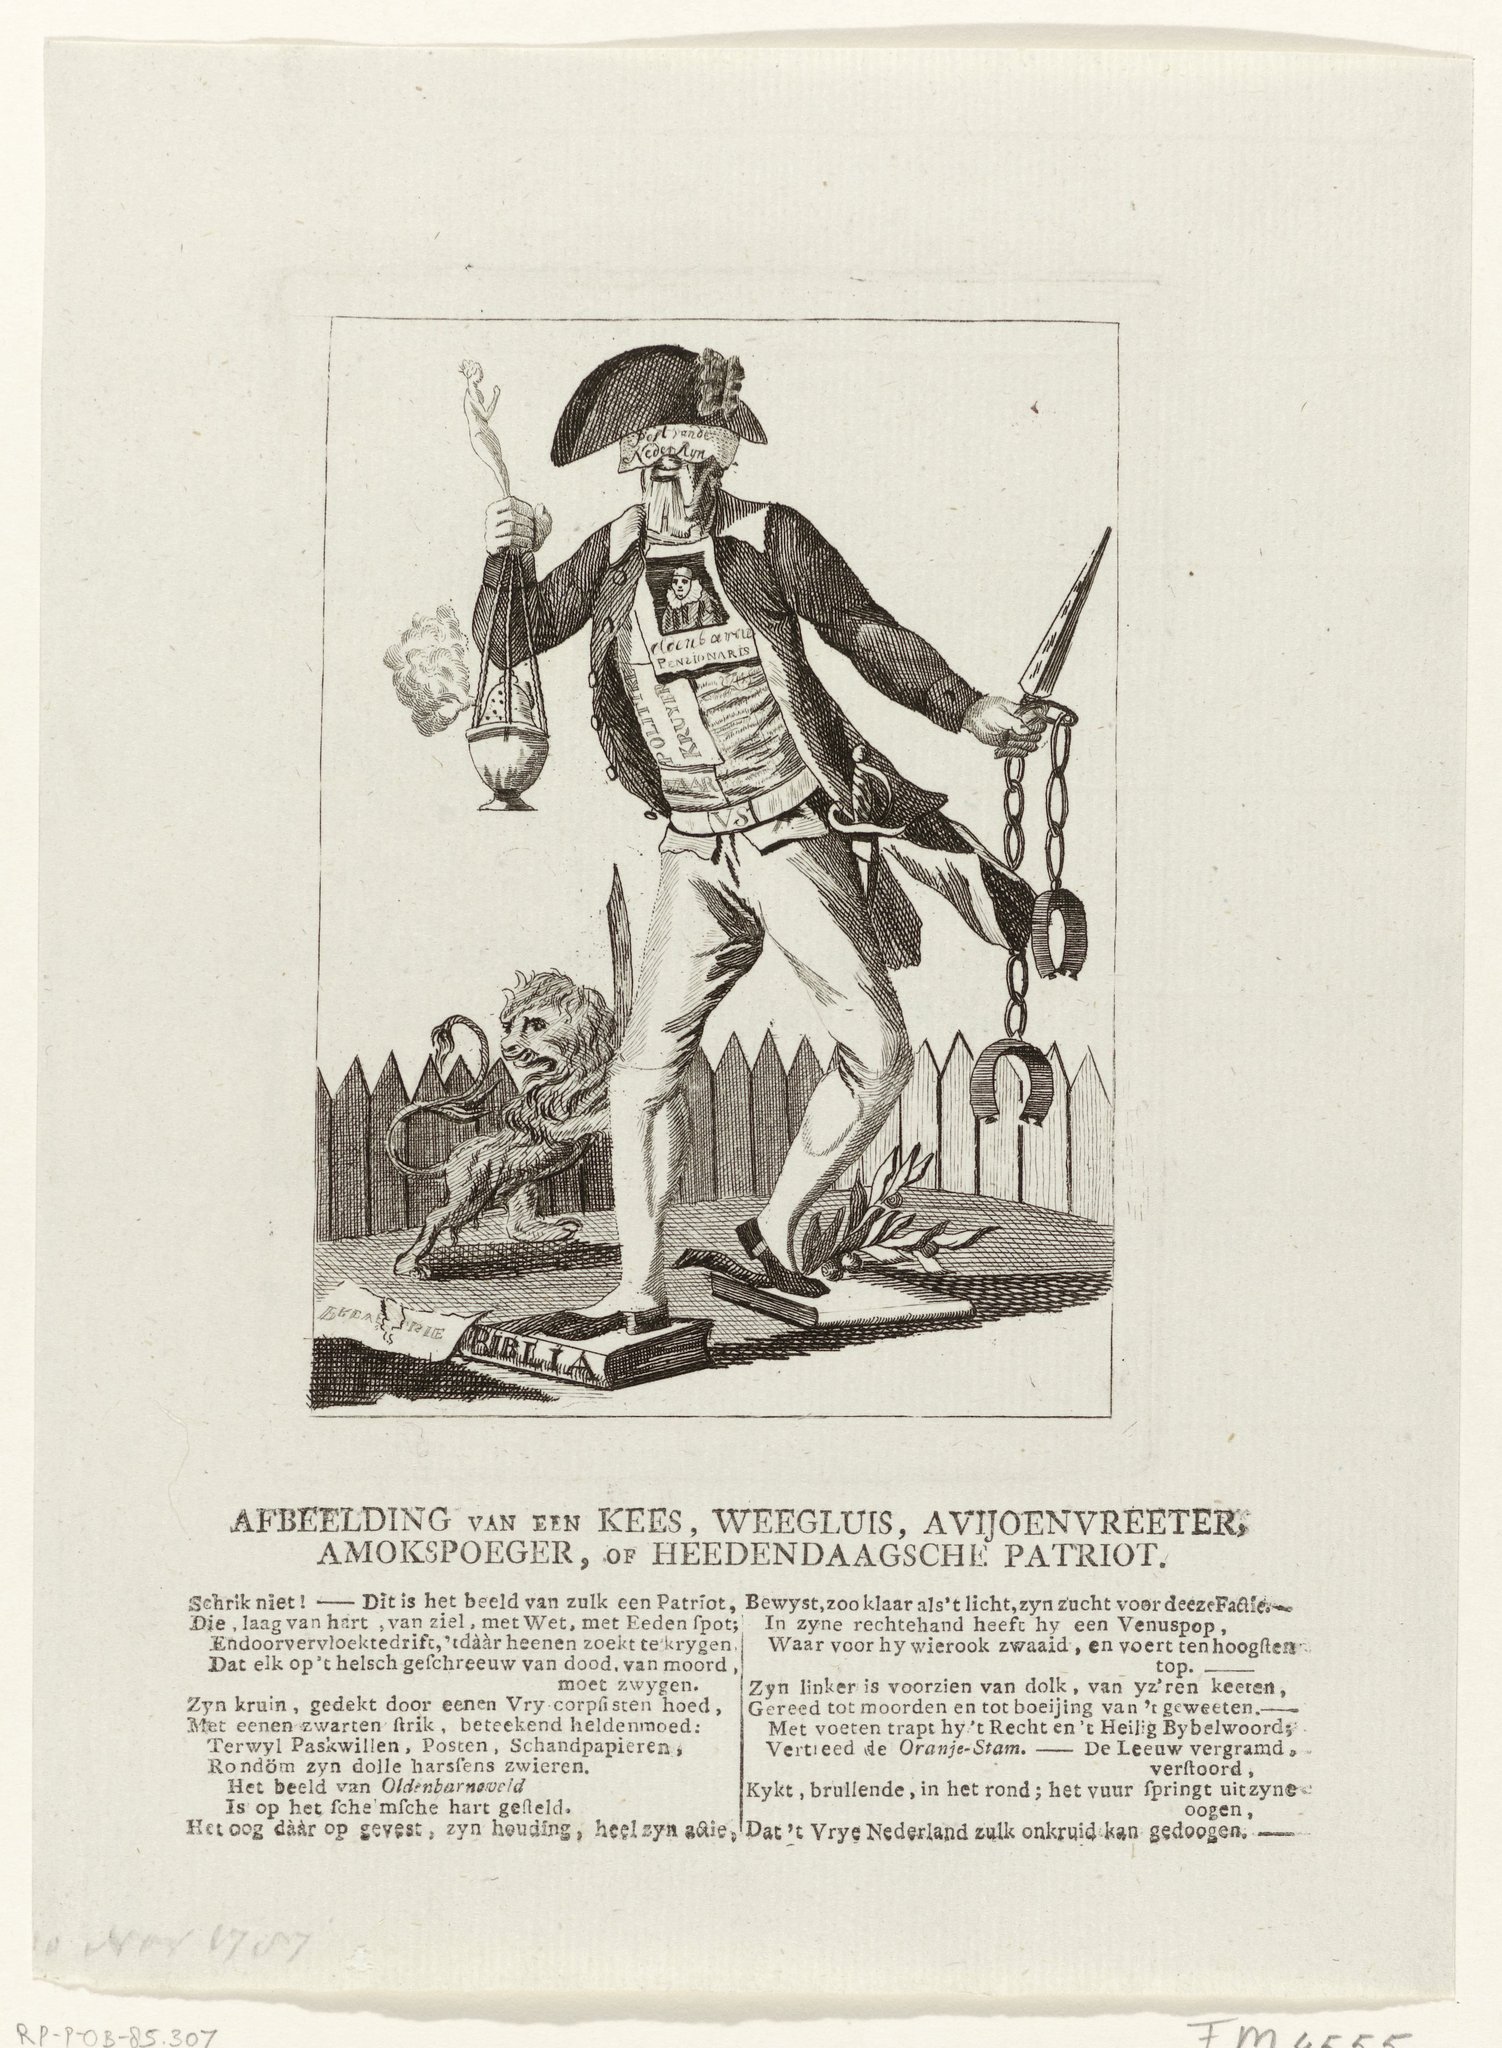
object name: print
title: Spotprent op de patriot Pieter de Waal, 1784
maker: Anonymous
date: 1784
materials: paper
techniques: engraving, etching, letterpress printing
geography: northern netherlands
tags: anthropomorphic beings with parts of abnormal shape - aa - female human figure, rotterdam, patriots (1780-1795)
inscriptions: collector's mark: Lugt 2228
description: Spotprent op de adelborst Pieter de Waal van de Negende Burgercompagnie te Rotterdam, die tijdens het geweld op 7 april 1784 gewond raakte. Zijn gezicht en de borst zijn opgebouwd uit pamfletten van Oldenbarnevelt en patriotse tijdschriften. Hij vertreedt de Bijbel en een Oranjetak. In de handen een wierookvat, dolk en boeien. Op met blad onder een vers in twee kolommen.